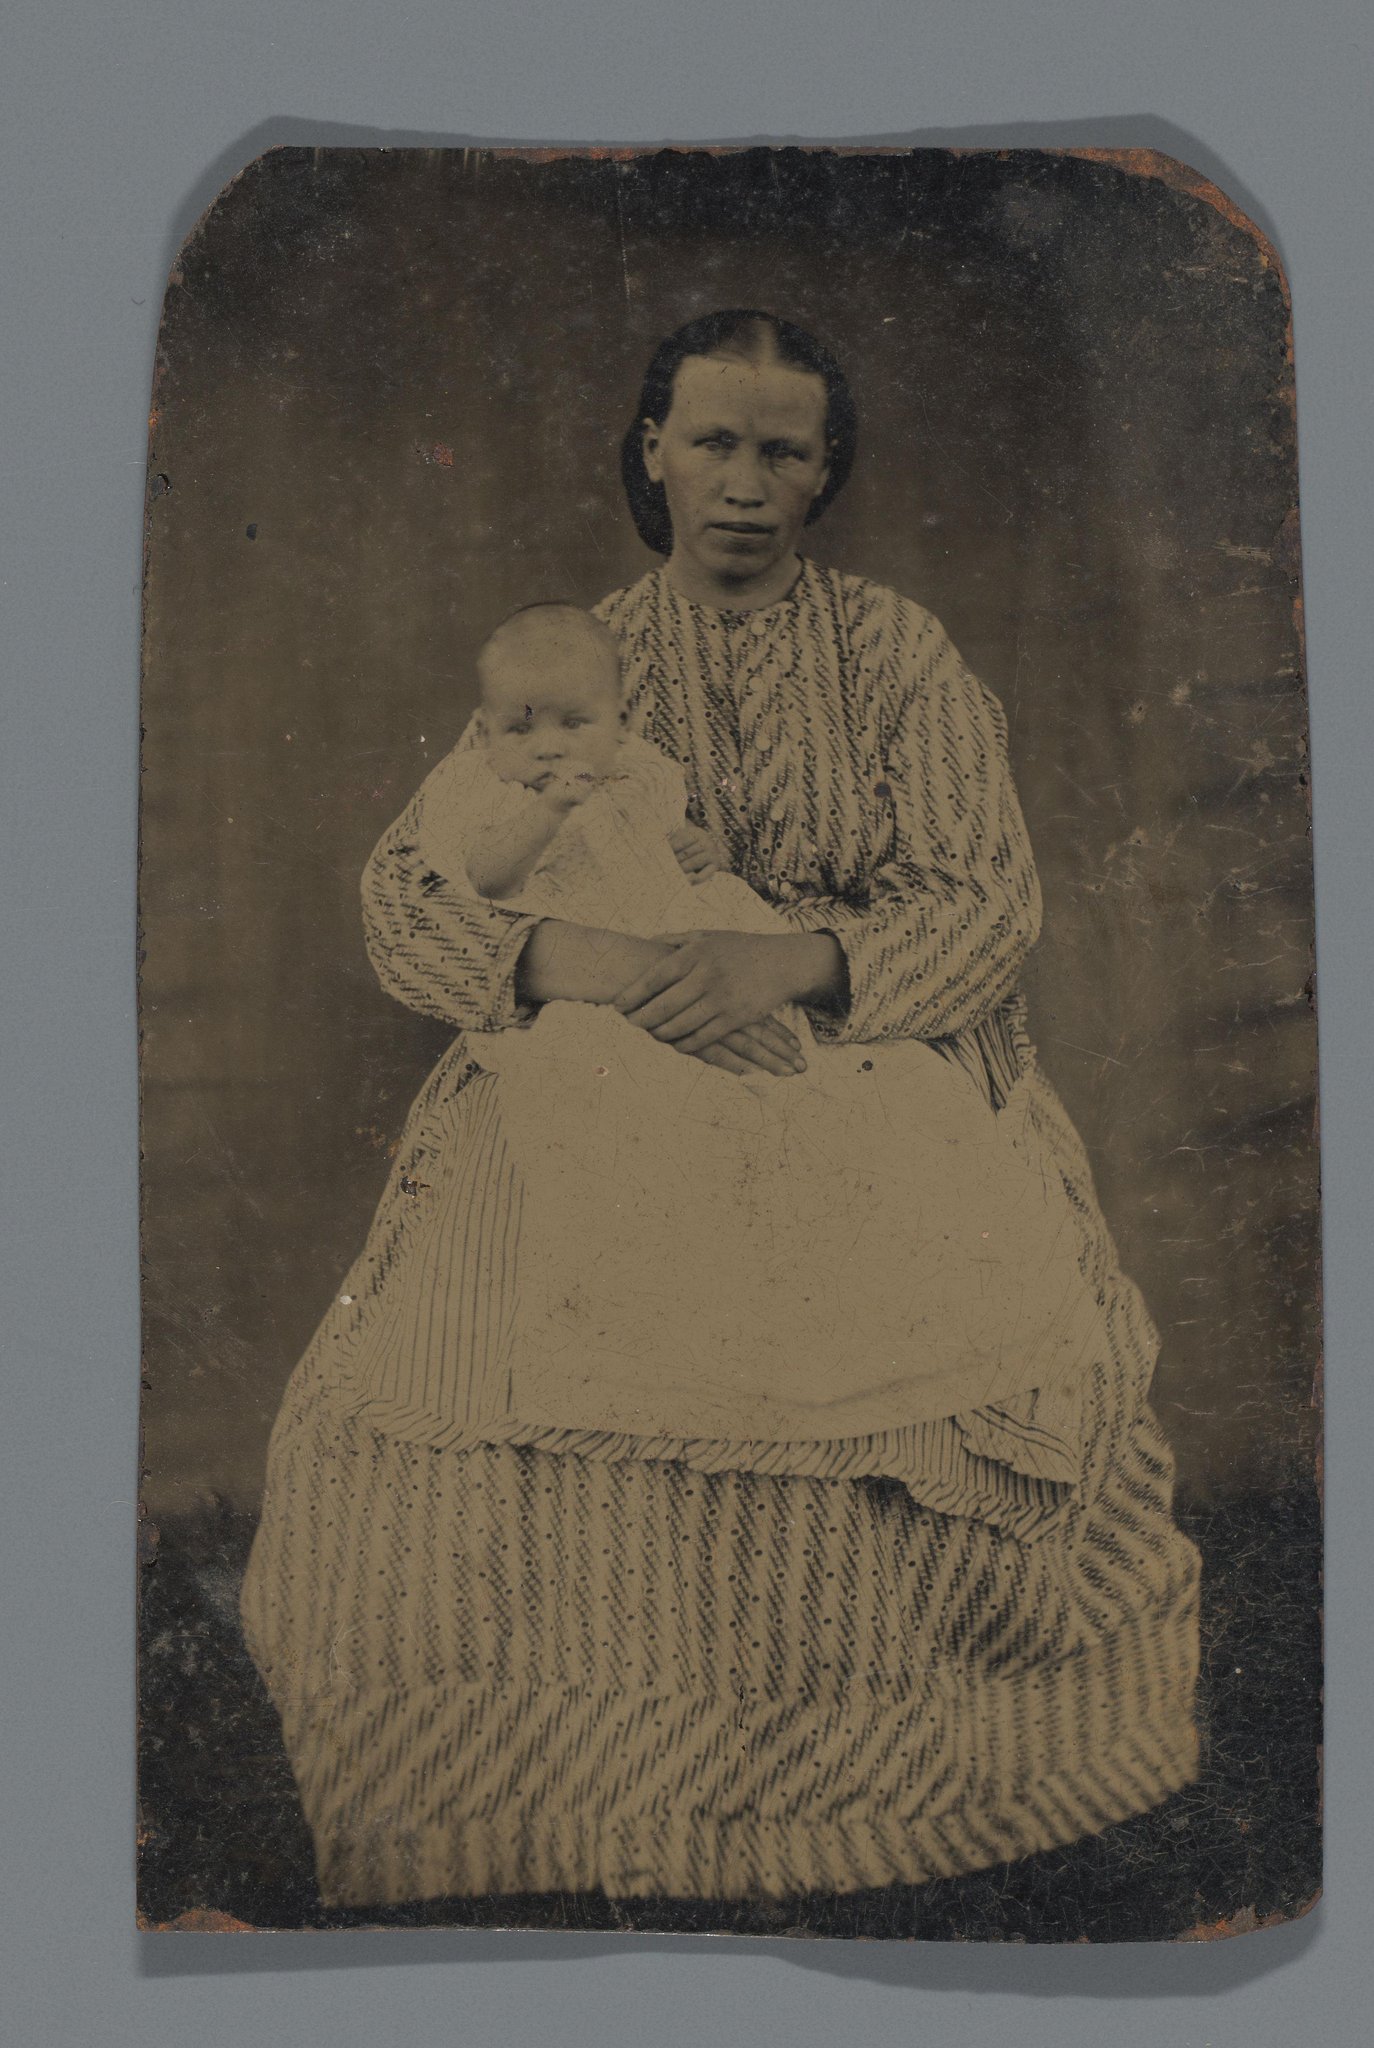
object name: photobook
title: Vrouw met baby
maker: Anonymous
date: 1870-1910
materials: photographic support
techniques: ferrotyping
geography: united states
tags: united states of america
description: Zittende Zwarte vrouw met middenscheding in lichte gestreepte japon met witte baby op schoot.